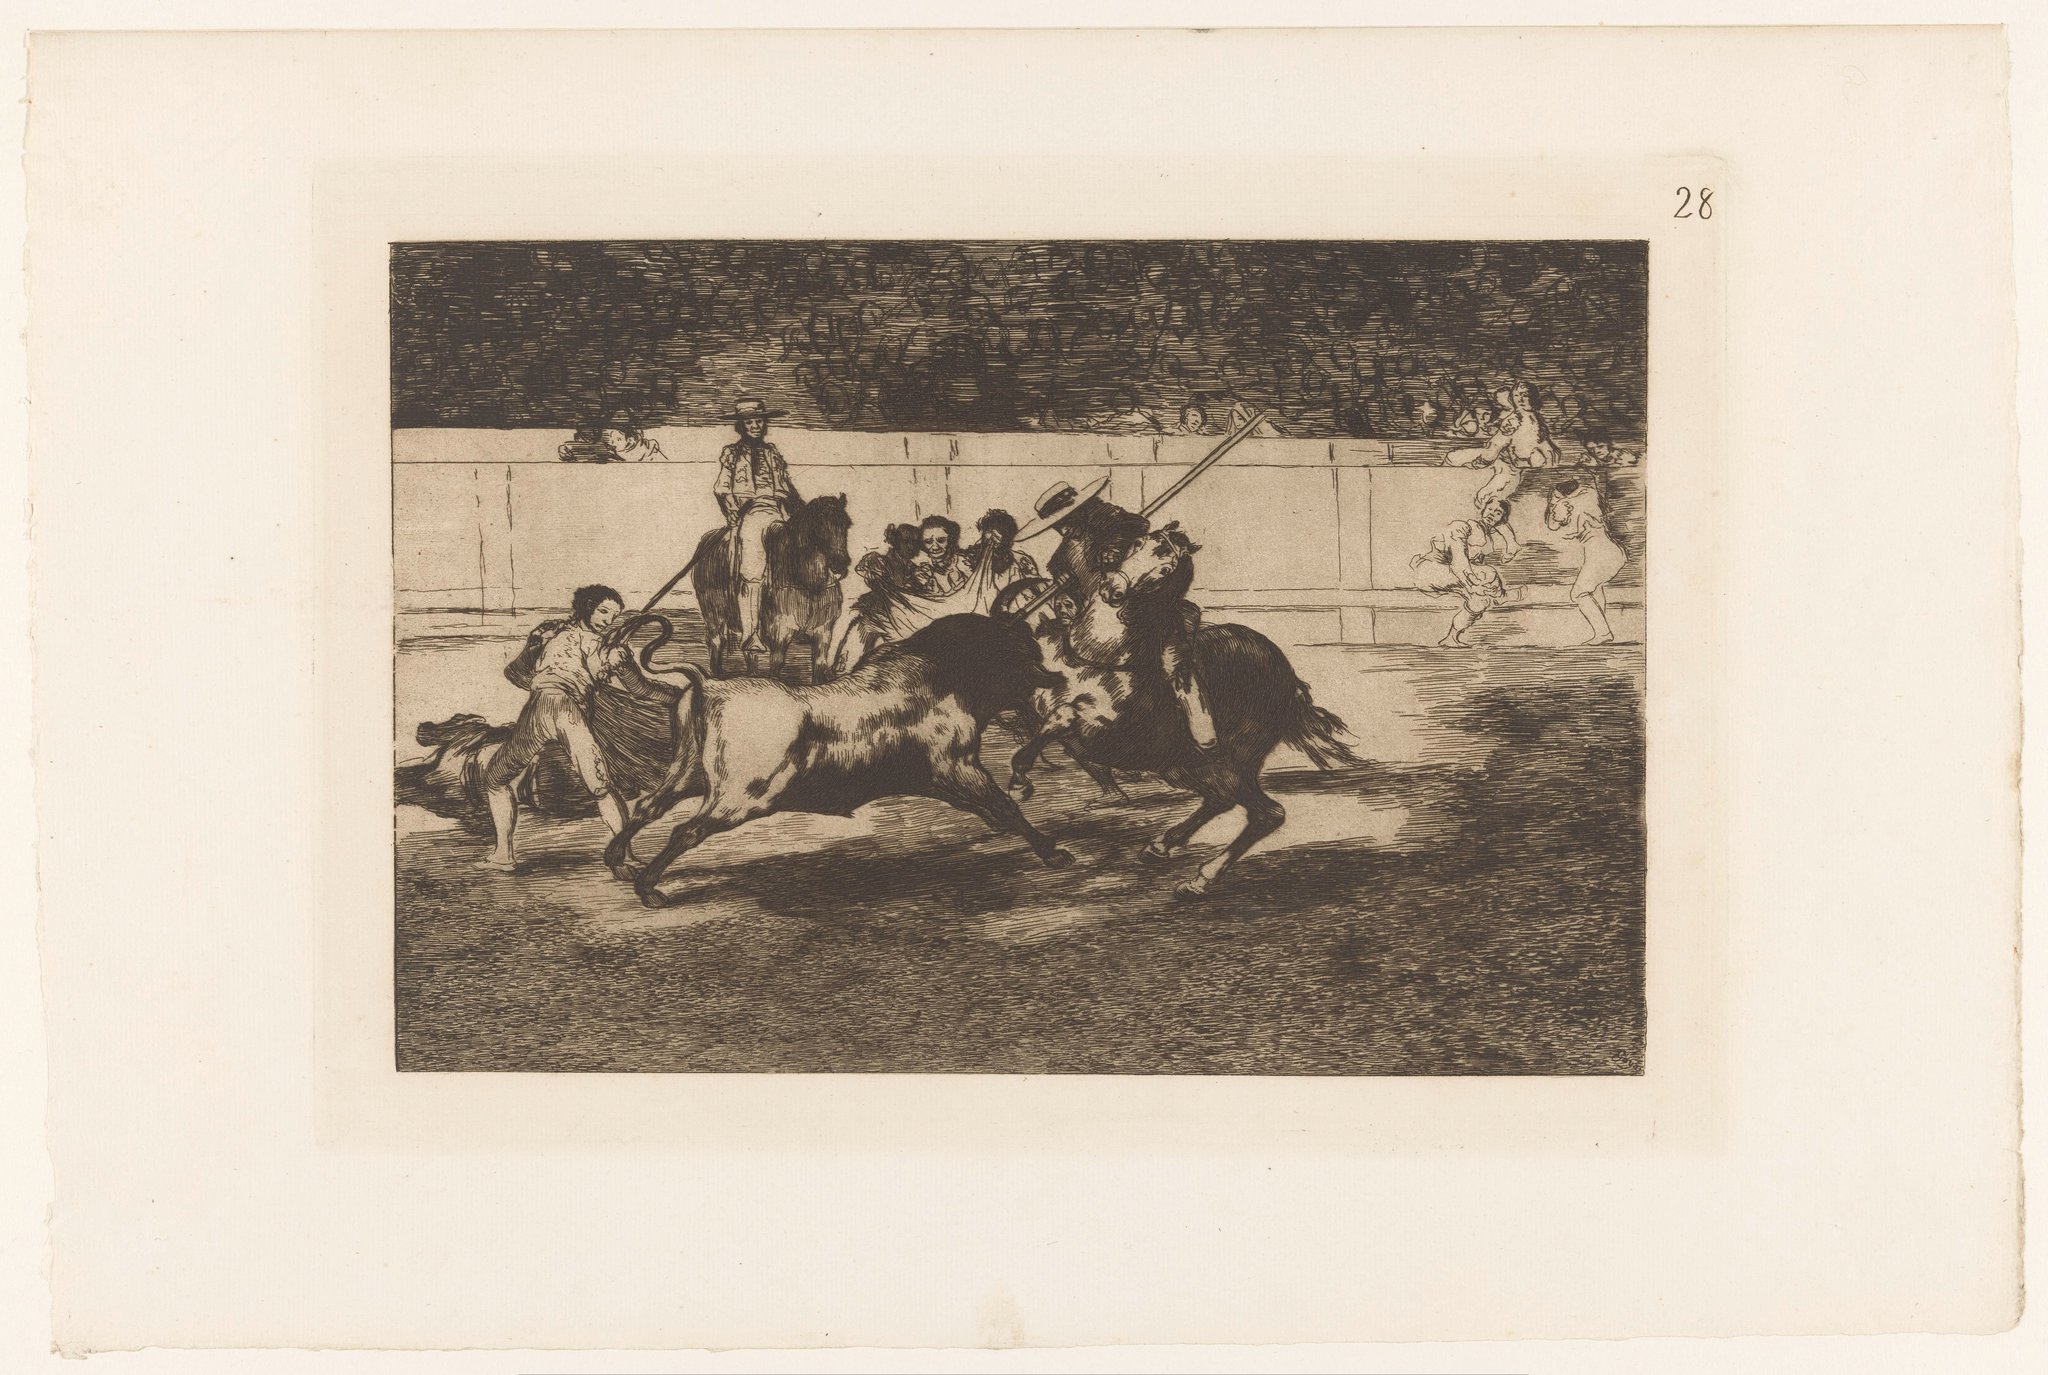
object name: print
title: Stierengevechten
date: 1876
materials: paper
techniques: aquatint, etching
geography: paris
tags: bullfight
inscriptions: collector's mark: Lugt 2228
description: Deze prent maakt deel uit van een serie van 40 prenten door Francisco de Goya met voorstellingen van stierengevechten. De eerste editie bestond uit 33 genummerde prenten en werd uitgegeven in 1816. Dit betreft de derde editie, uitgegeven in 1876 door Eugène Loizelet en door hem voorzien van een titelprent en lijst met titels. Naast de 33 prenten publiceerde Loizelet ook de prenten die door Goya op de achterkanten van 7 van de platen werden geëtst. Deze zijn niet voorzien van nummers maar van de letters A-G.